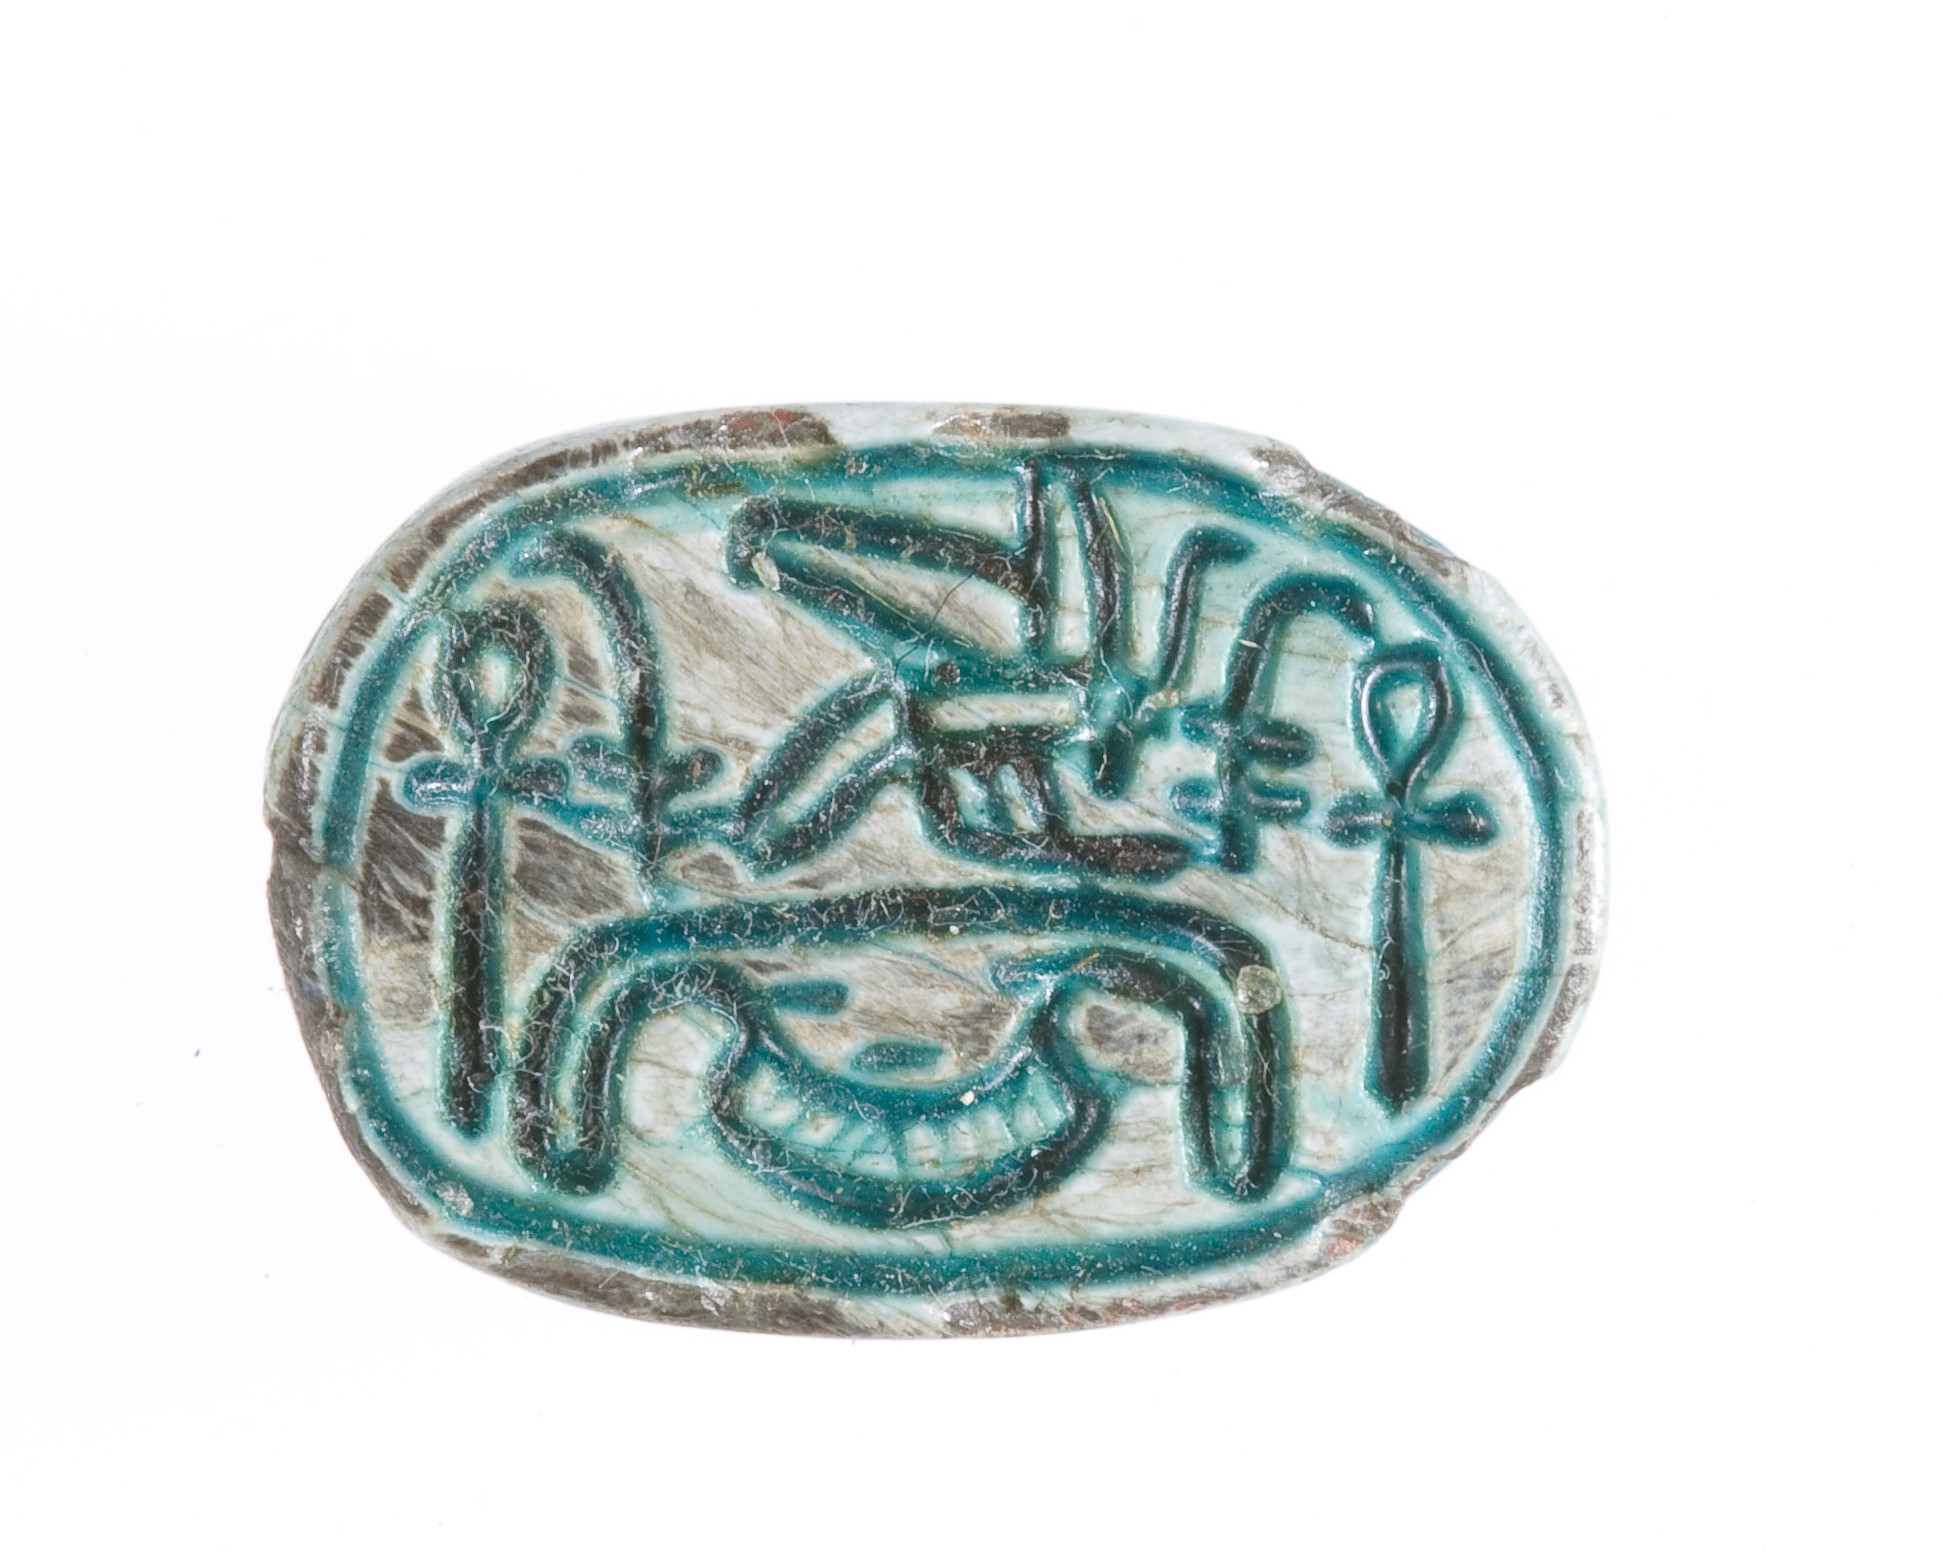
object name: scarab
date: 1635-1458 BCE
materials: stone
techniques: glazing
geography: egypt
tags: scarabs